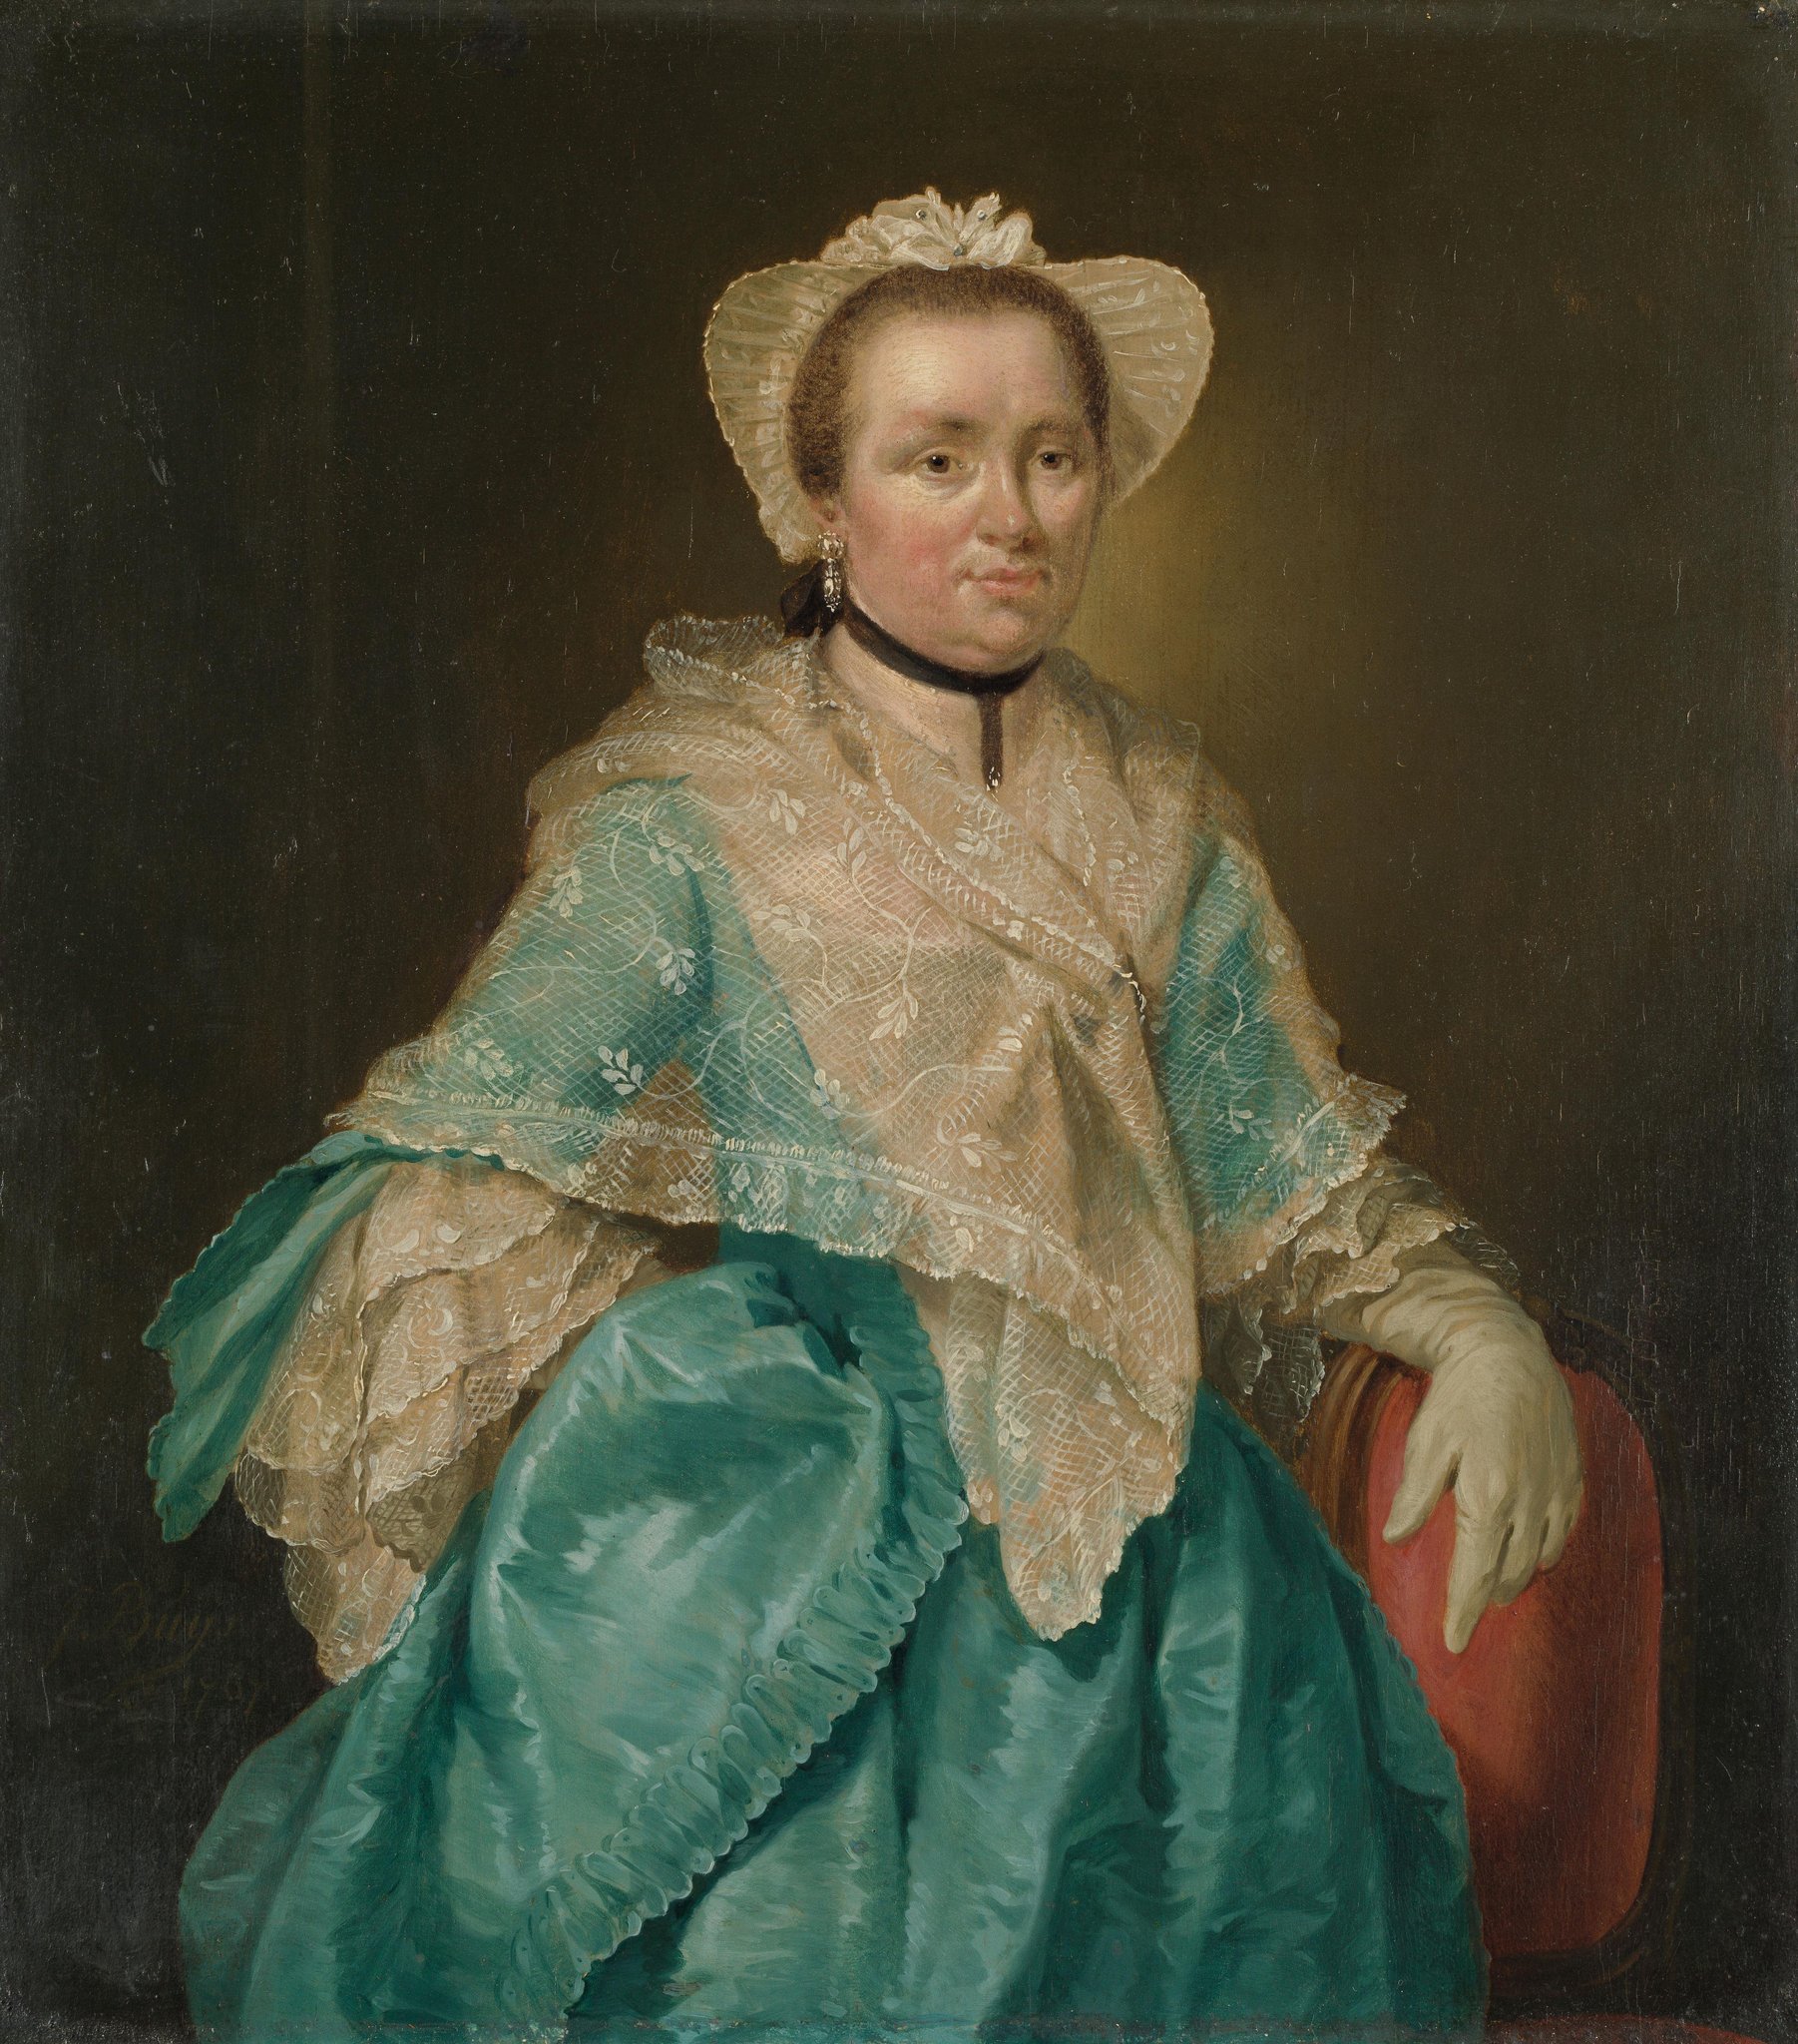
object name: painting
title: Portrait of Elisabeth Troost (1730-1790)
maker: jacobus buys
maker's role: draughtsman, print maker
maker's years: 1724-1801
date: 1767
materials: oil, panel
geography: amsterdam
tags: historical persons - bb - woman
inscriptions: seal, signature and date: ‘J. Buys // 1767’, label: ‘Elisabeth Troost // Dochter van de Amsterdamsche // Gebooren Amsterdam //Den 17 November 1730 // Haar ouders waaren // Cornelis Troost // Susanna van der Duyn // Trouwt 10 Mey 1750 // Corn. Ploos van Amstel // [...]’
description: Van zowel de familie Troost als de familie Ploos van Amstel zijn veel portretten bekend, deels nog in familiebezit. Het bekendst zijn de pendanten van Cornelis Ploos van Amstel en Elisabeth Troost door George van der Mijn, 1748 (Mauritshuis) geschilderd tijdens hun verlovingstijd. Met de verwerving van het portret van Elisabeth Troost door Jacob Buys uit 1767 komt daar een tweede groep bij, nu van beiden als echtgenoten. Het portret van Cornelis Ploos van Amstel door Jacob Buys (SK-C-515) bevindt zich sinds 1899 in bruikleen in het Rijksmuseum en wordt getoond op zaal over de Verlichting in de 18de eeuw. Ploos was een belangrijke verzamelaar, vernieuwer in de prentkunst en kunsttheoreticus. Wanneer een 'companion-portrait' opduikt, is dat op zichzelf al reden tot verwerving, het completeert immers het andere portret. In het geval van Elisabeth Troost is de toegevoegde waarde dat we over haar, via egodocumenten van Ploos van Amstel en de biografie van haar vader, de schilder Cornelis Troost, het nodige weten. Strikt genomen is haar portret geen echt pendant, aangezien de houding verschilt en het een jaar later is geschilderd dan het portret van de echtgenoot. De maten zijn echter identiek en de twee portretten hingen blijkens een oude inventarislijst in dezelfde kamer. Ze worden op die lijst ook gezamenlijk opgevoerd. Het feit dat Elisabeth links staat - op zich vrij ongebruikelijk voor pendanten - is uit deze ontstaansgeschiedenis goed te verklaren. Overigens blijken nu ook in het oeuvre van Liotard meerdere pendanten te zijn met de vrouw links, dus wellicht was het een achttiende-eeuwse trend. Nader onderzoek hierover volgt. Op de achterzijde van het paneel is een briefje geplakt en oververnist, waarop Cornelis Ploos van Amstel de gegevens van de geportretteerde heeft geschreven. Het heeft zijn embleem en is verzegeld met het zegel van Ploos van Amstel. Op andere portretten uit de collectie van Ploos van Amstel bevinden zich soortgelijke identificerende briefjes (Niemeijer 1962). Ploos noteerde bovendien ook aan de achterzijde van de schilderijen uit zijn collectie herkomst- en identificatiegegevens.